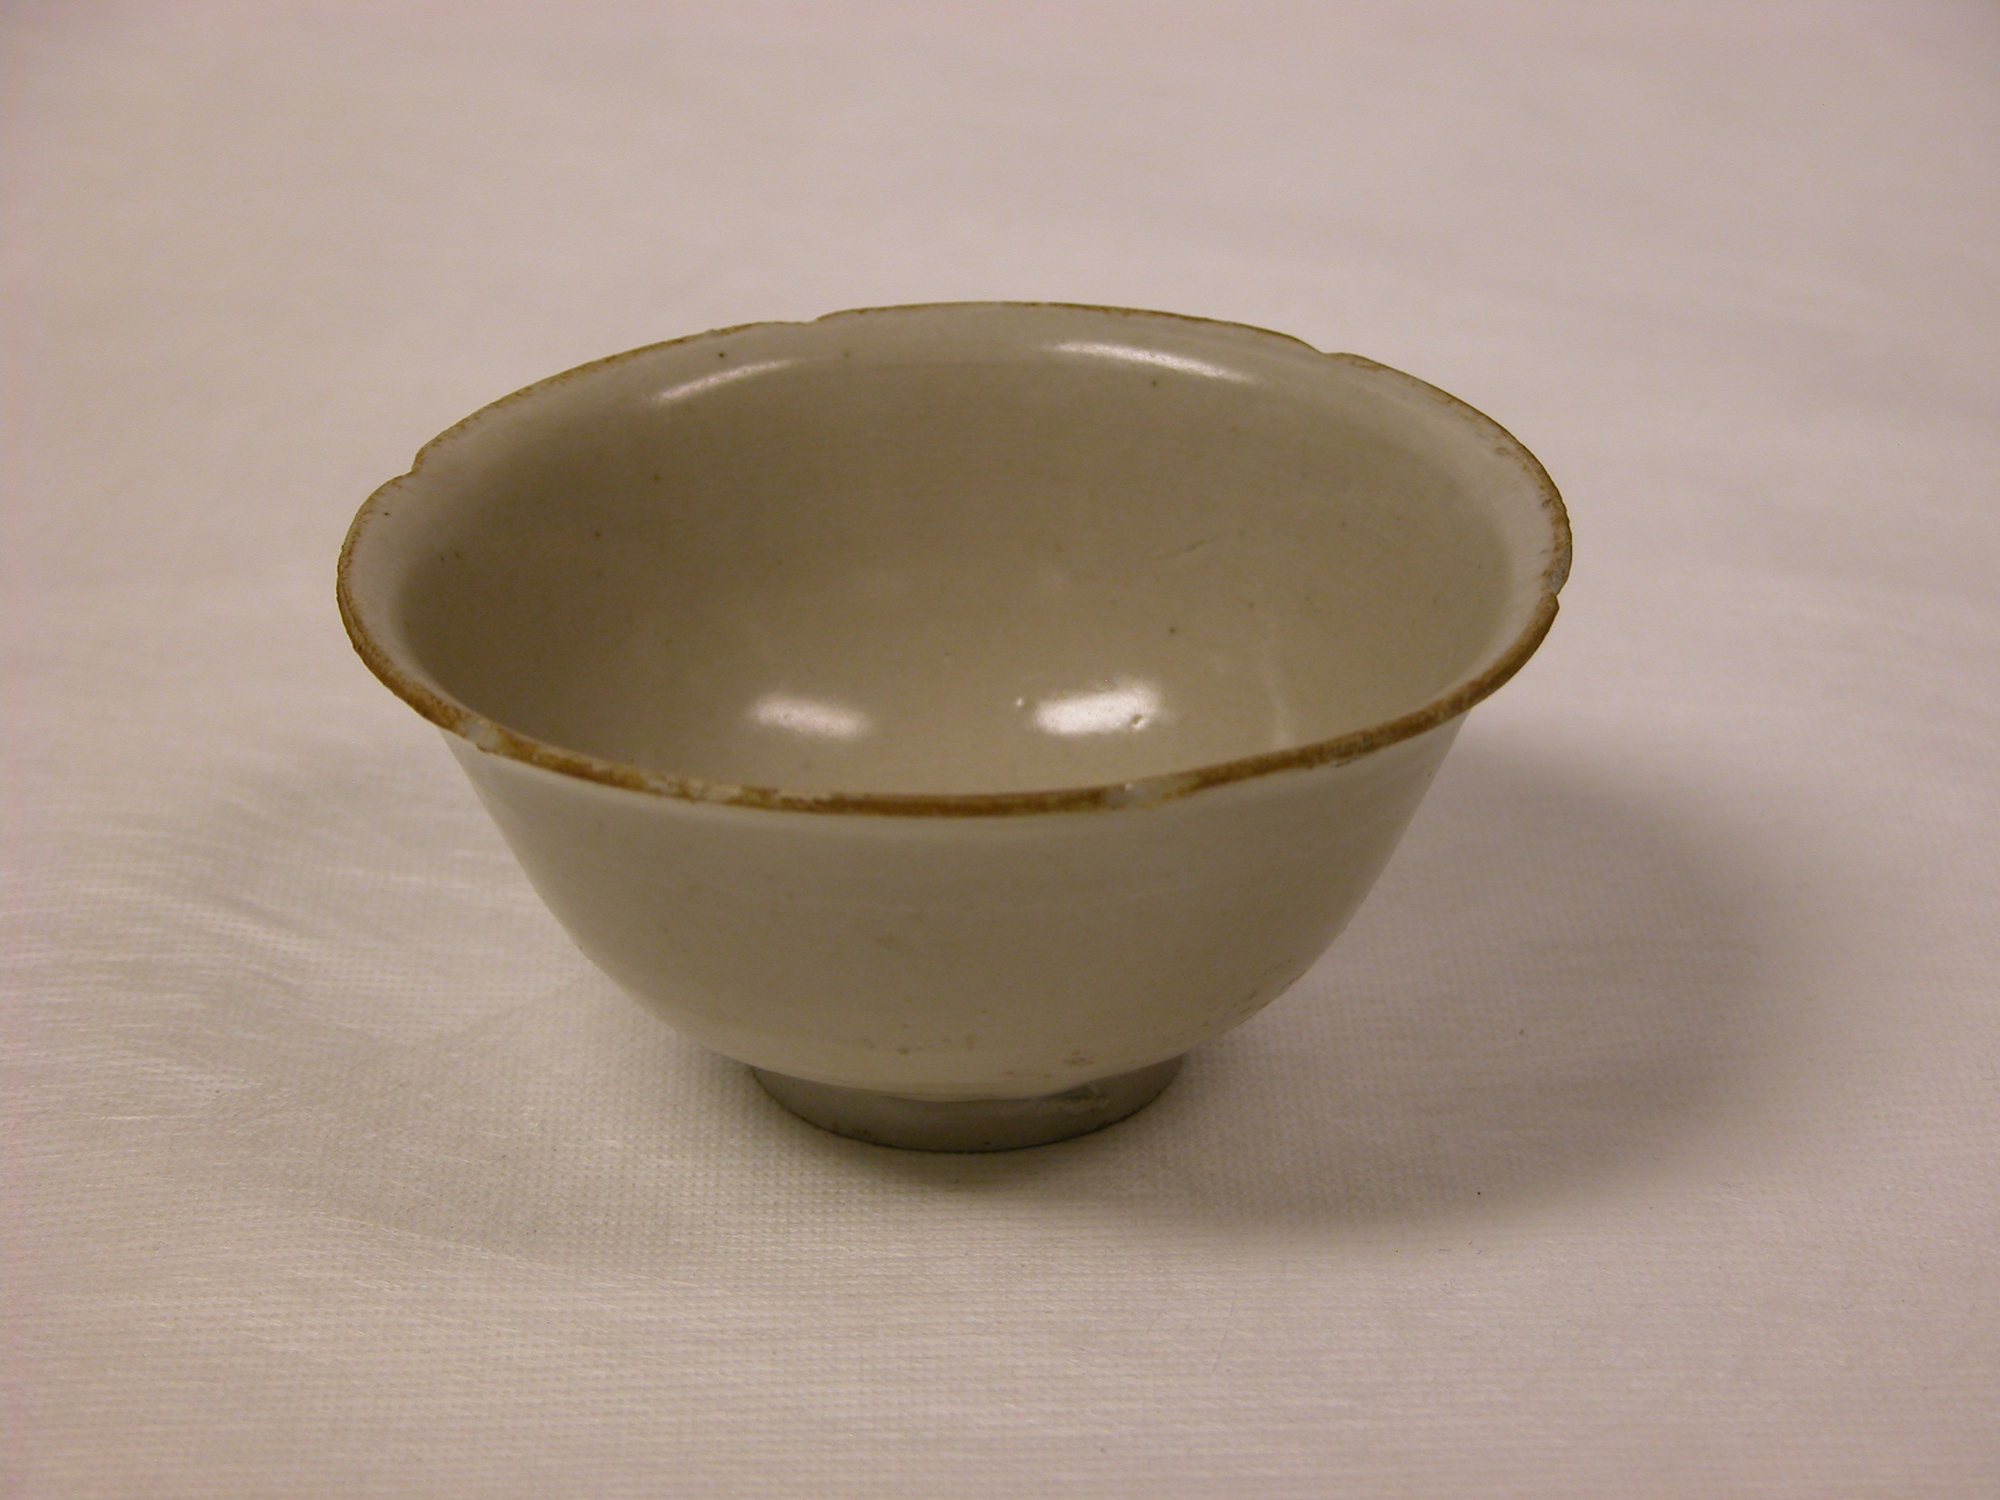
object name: bowl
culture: chinese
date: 960-1279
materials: stoneware